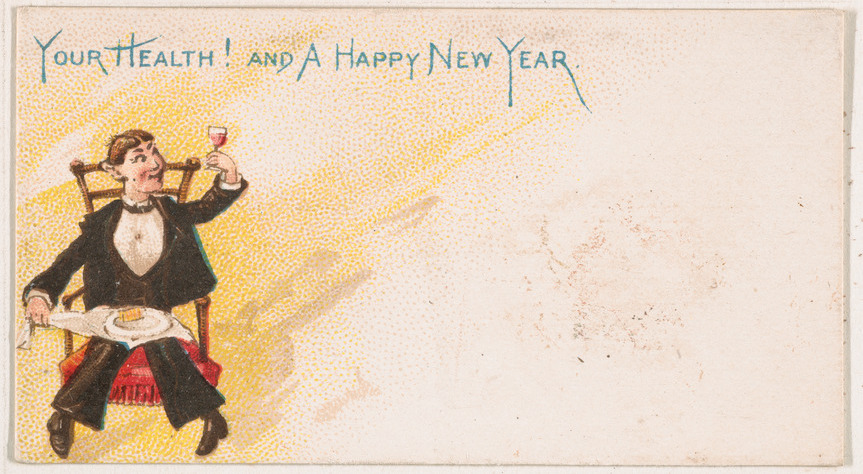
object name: print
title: Your Health! And a Happy New Year, from the New Years 1890 series (N227) issued by Kinney Bros.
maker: kinney brothers tobacco company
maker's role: publisher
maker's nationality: american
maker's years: 1869-2011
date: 1889-1890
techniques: color lithograph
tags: men,drinking